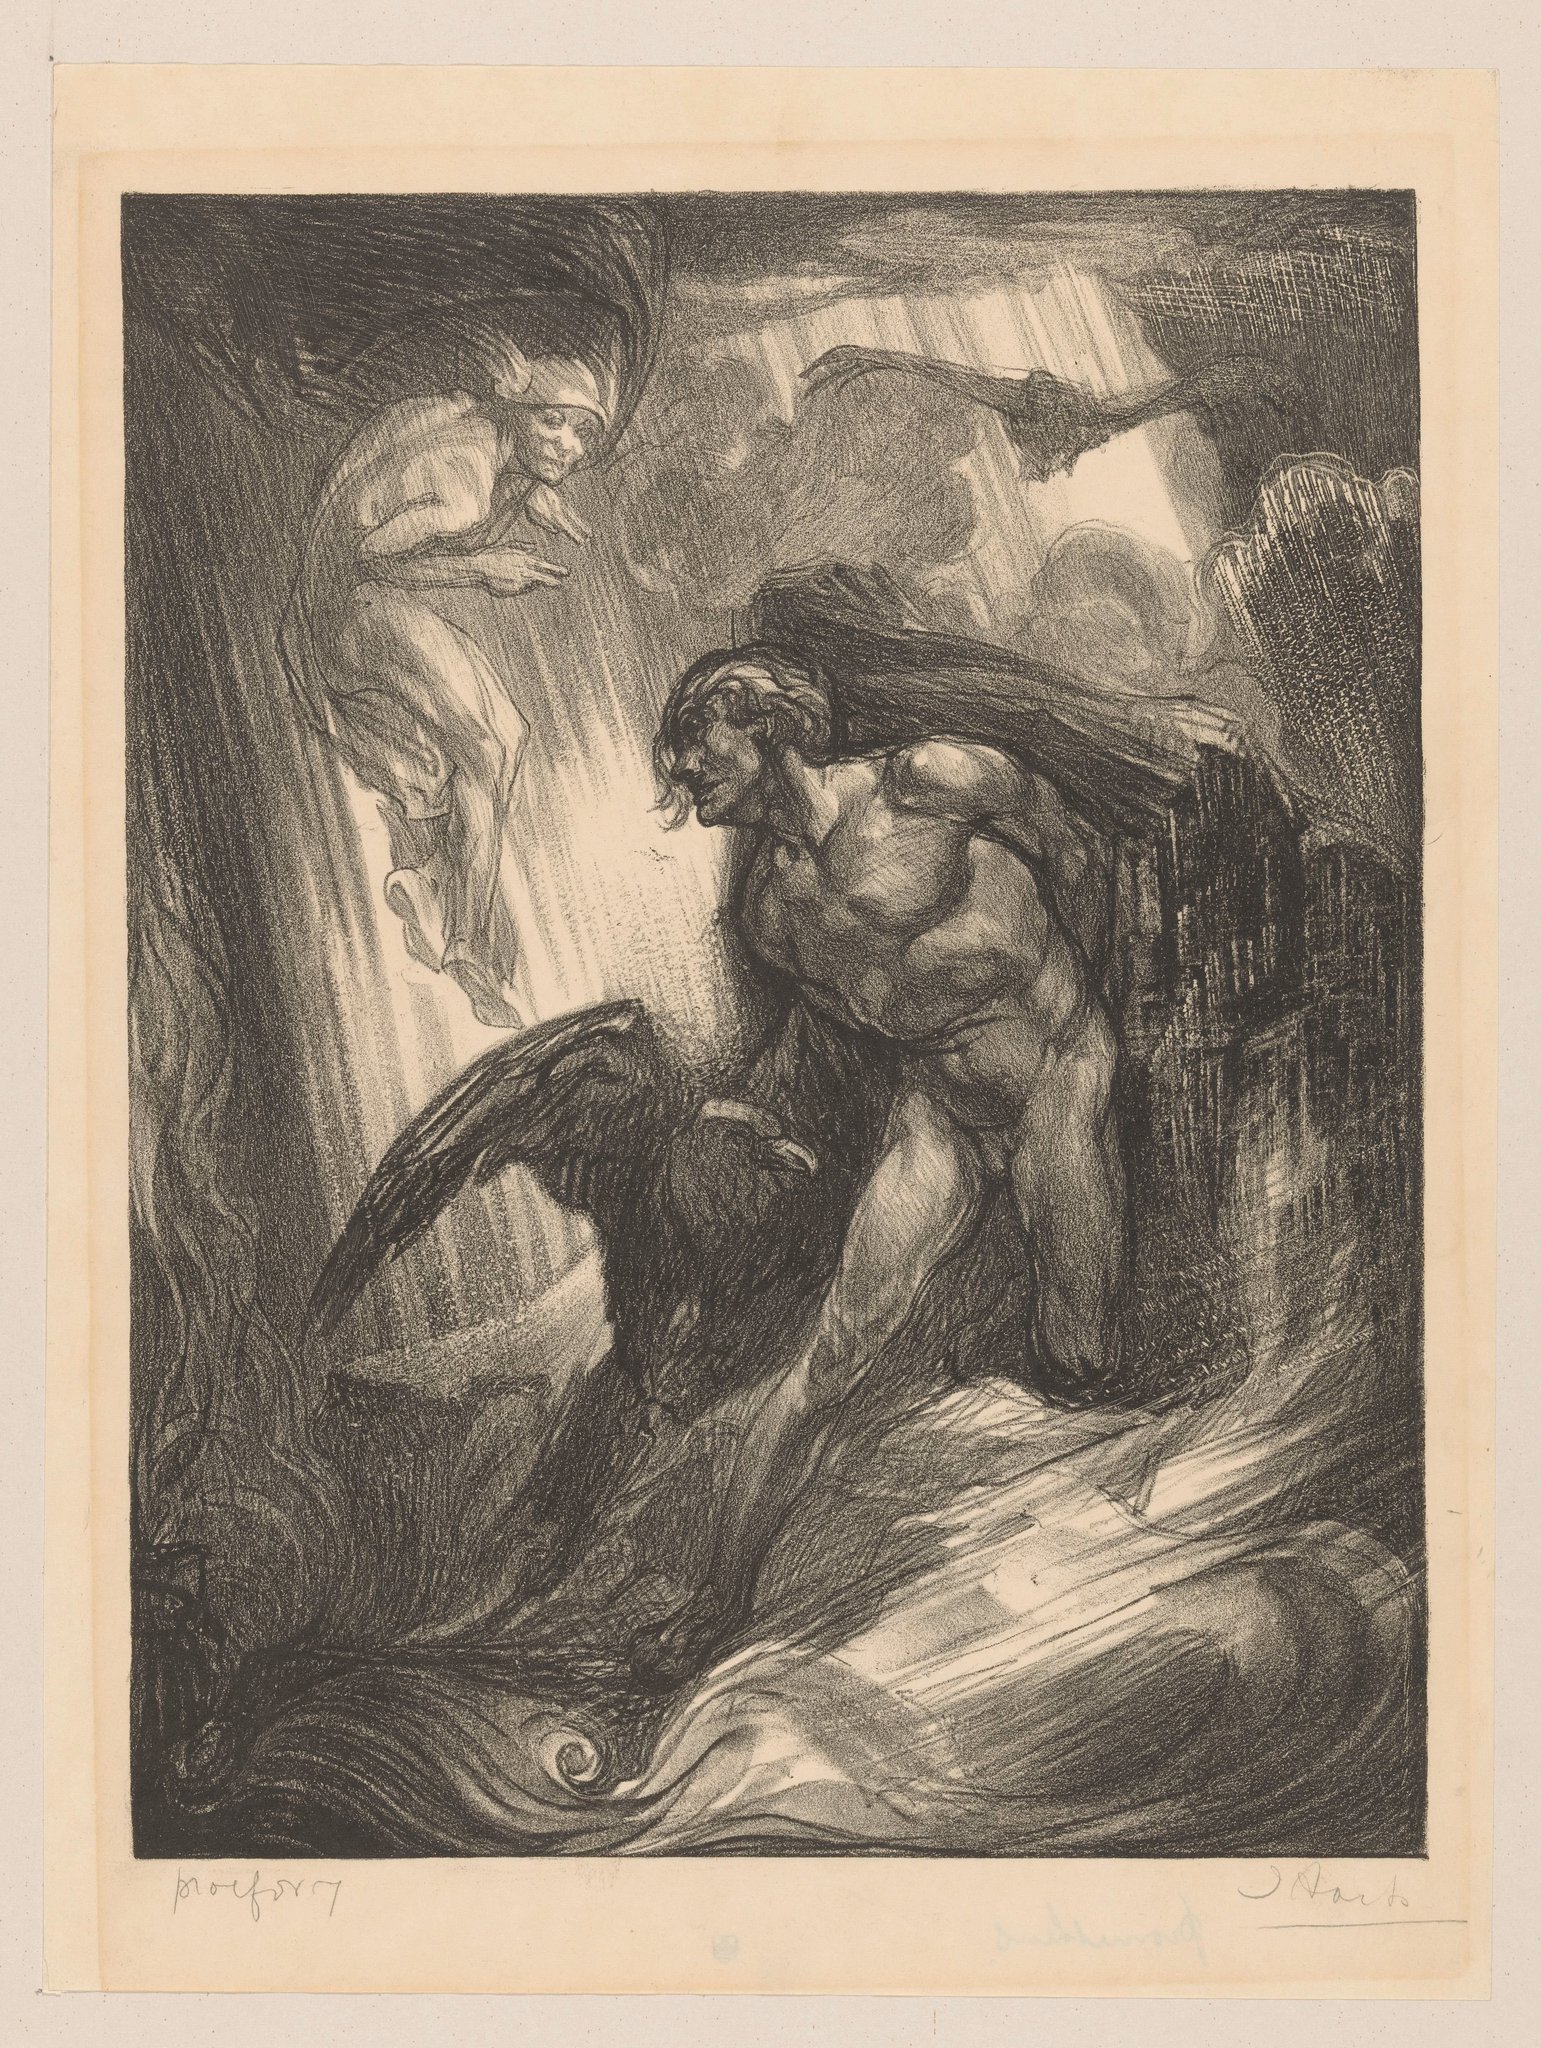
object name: print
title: De foltering van Prometheus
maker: johannes josephus aarts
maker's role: draughtsman, print maker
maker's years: 1871-1934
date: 1881-1934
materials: paper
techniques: lithograph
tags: punishment of prometheus; he is chained to a rock, usually by vulcan and/or mercury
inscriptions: collector's mark: Lugt 2228, collector's mark: Lugt 2760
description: Prometheus is naakt vastgeketend aan een rots. Een adelaar komt pikken aan zijn lever. Links op de voorgrond een brandende toorts, het vuur dat Prometheus stal van de goden. In de lucht Mercurius, die Prometheus vastketende aan de rots.